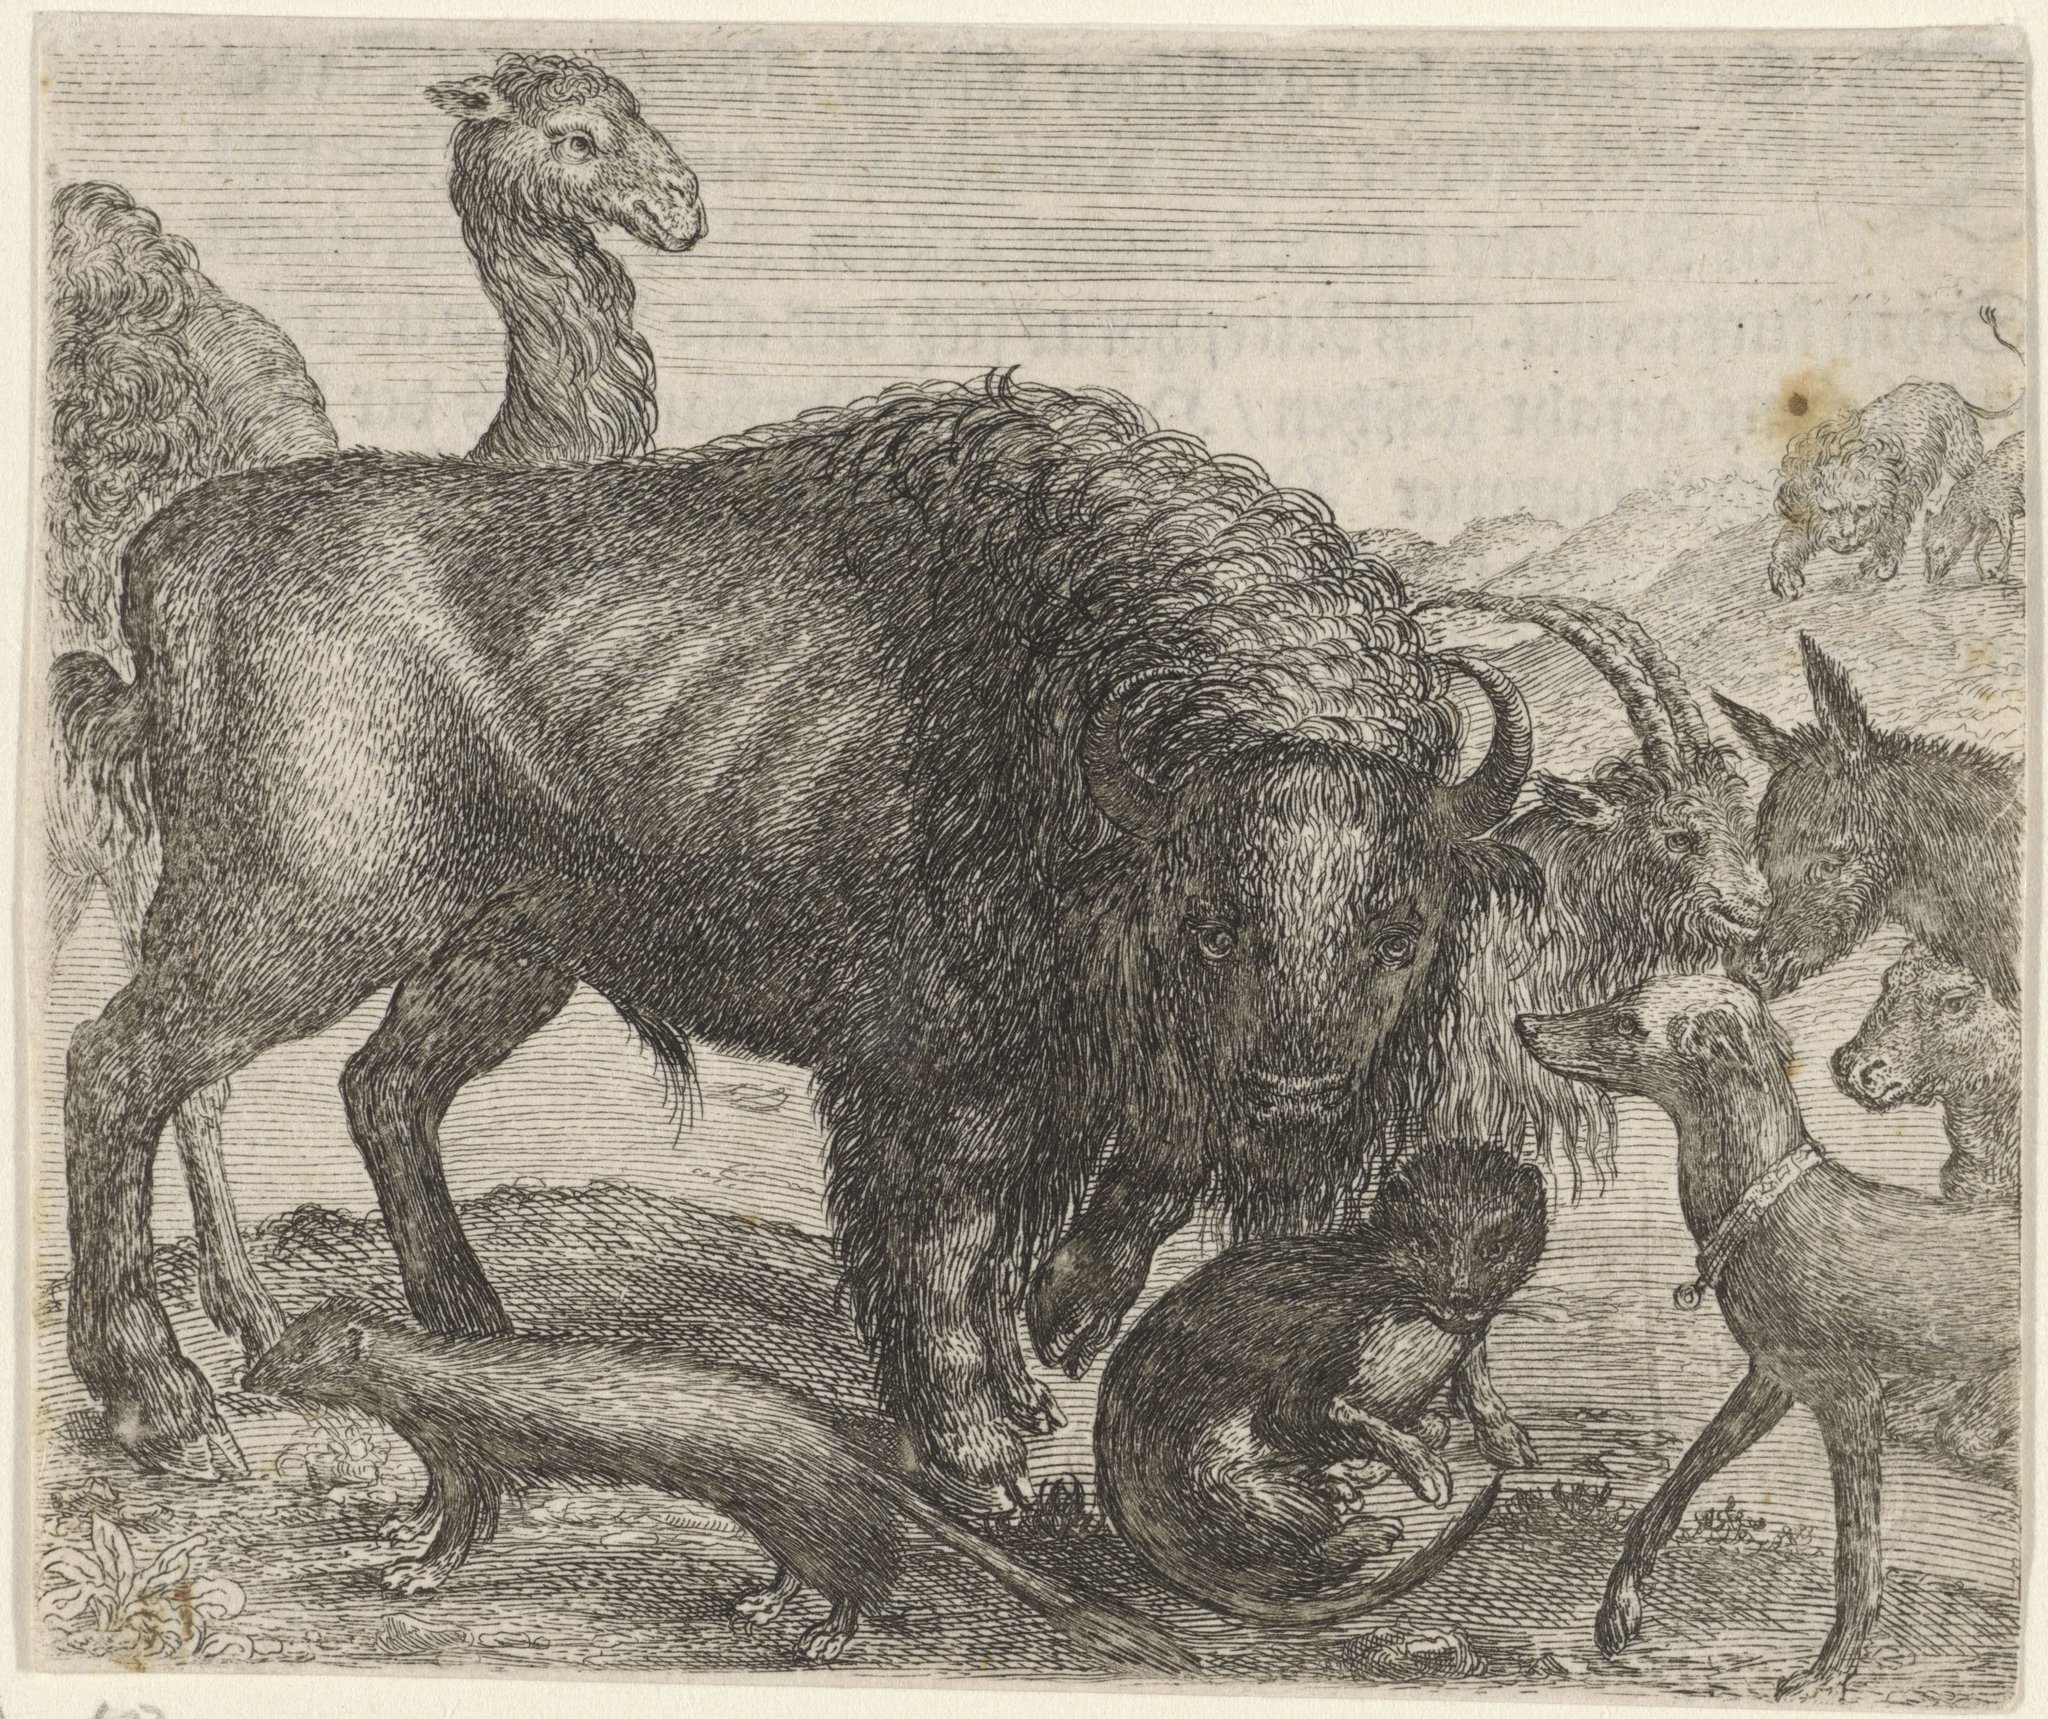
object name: book illustration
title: Fabel van de bizon en de andere dieren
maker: aegidius sadeler (ii)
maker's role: draughtsman, print maker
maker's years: 1568-1629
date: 1608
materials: paper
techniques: engraving, etching, letterpress printing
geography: prague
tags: hoofed animals: camel, cow, fables, goat, hoofed animals: bison, beasts of prey, predatory animals: fox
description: Een bizon, een vos, een hond, een koe, een kameel, een geit en een ezel op de voorgrond. Op de achtergrond een leeuw en een wolf. De moraal van het verhaal leert dat wie zich omringt met slecht gezelschap, hier ook de consequenties van moet dragen.